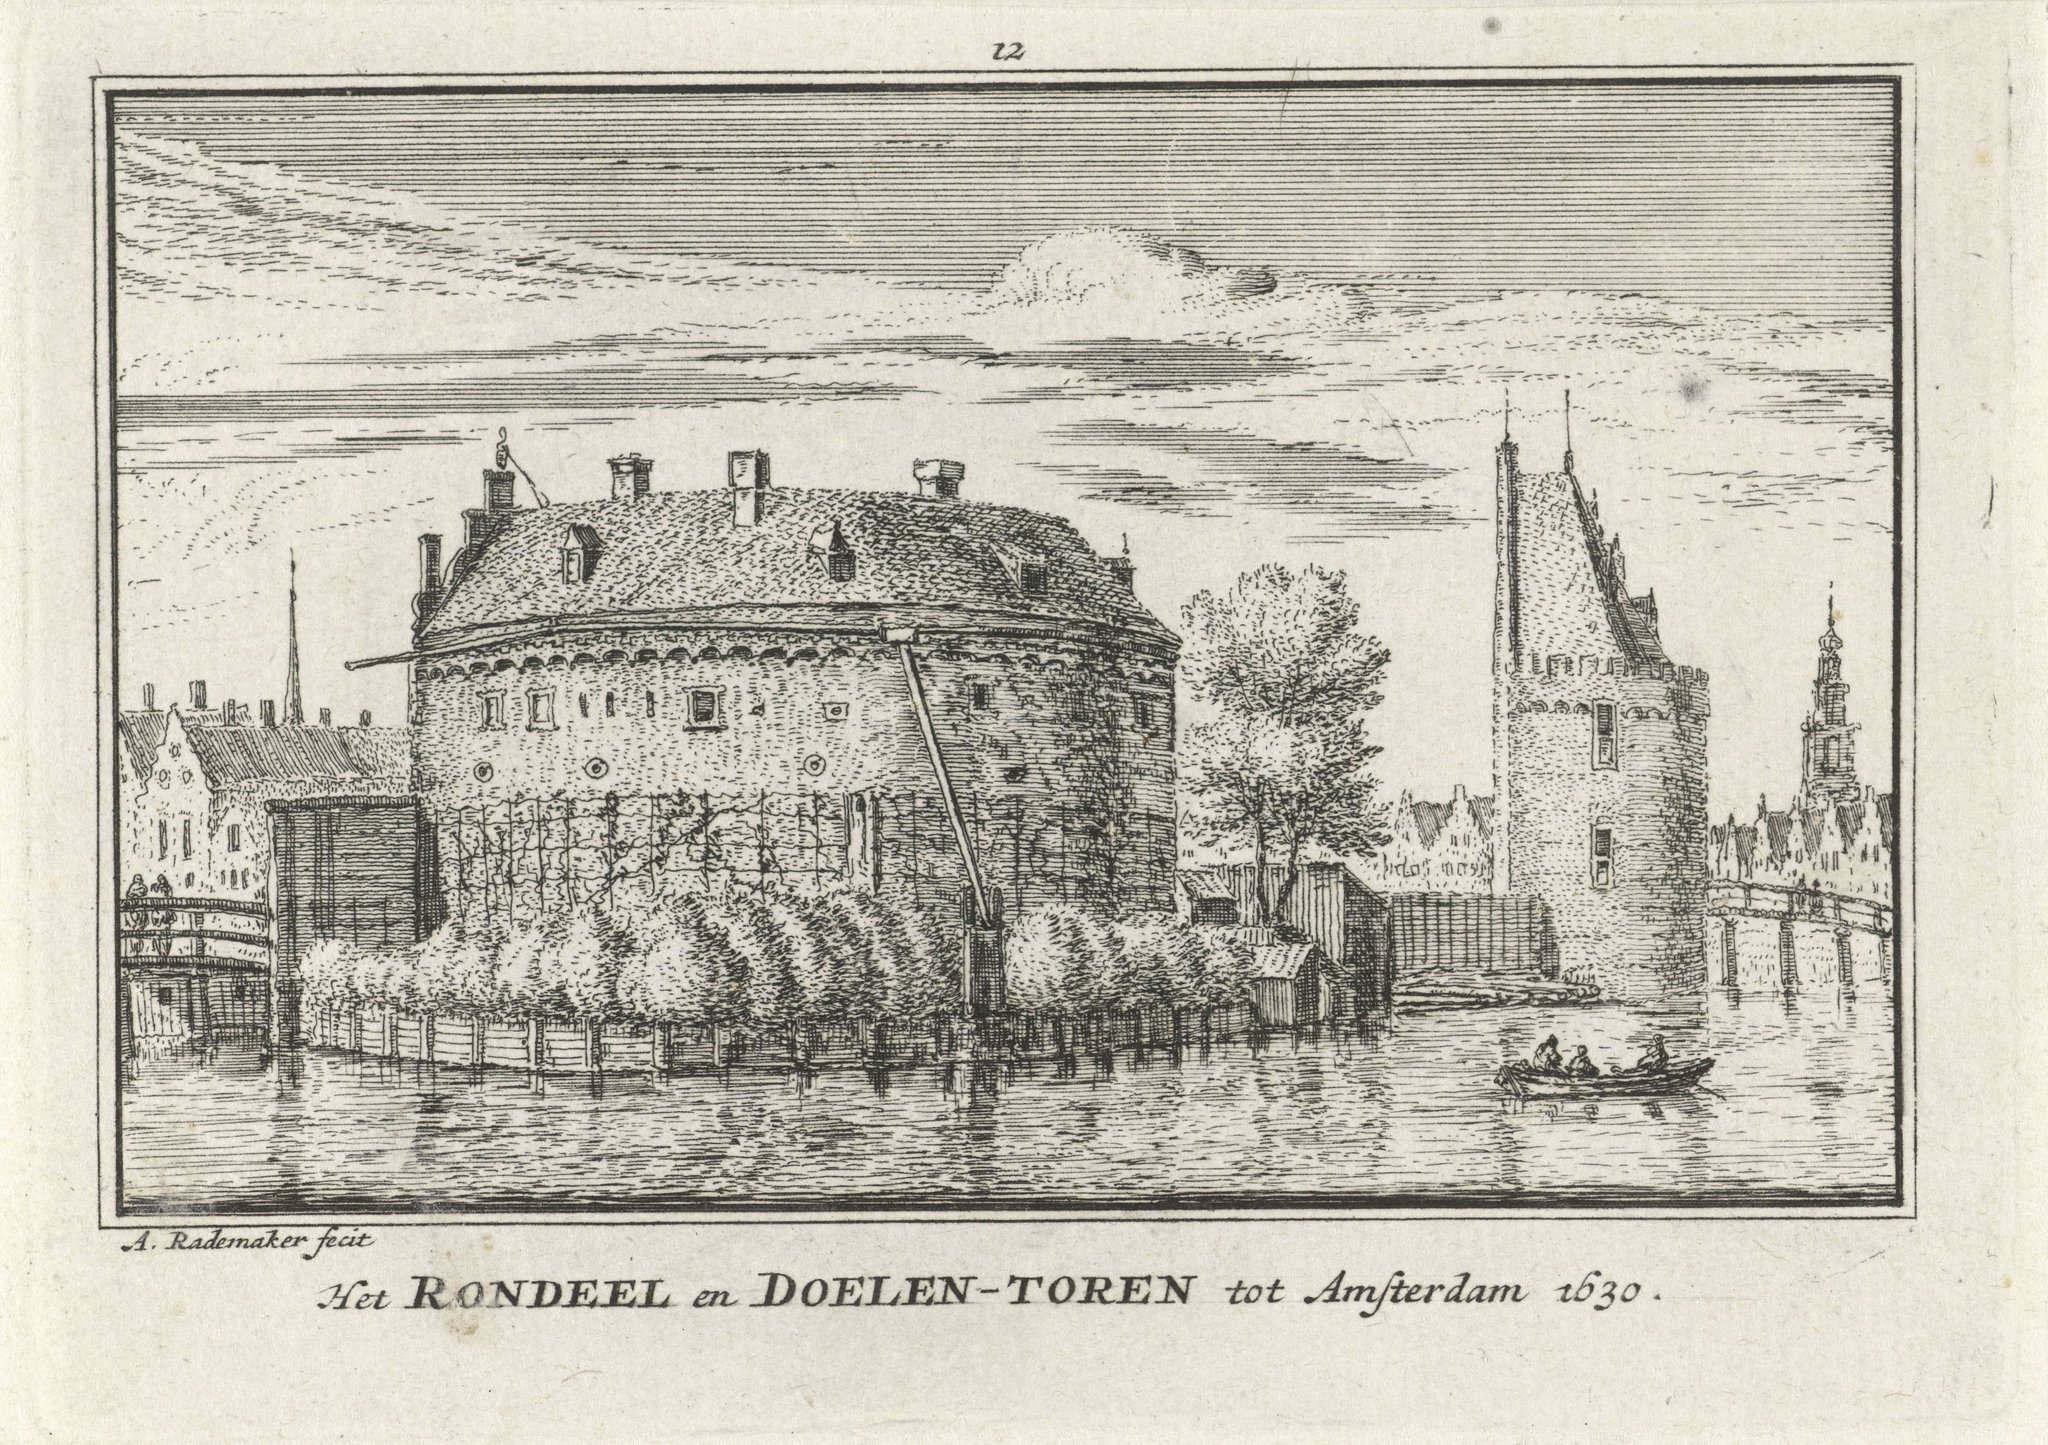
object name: book illustration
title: Het Rondeel en Doelen-Toren tot Amsterdam 1630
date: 1727-1733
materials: paper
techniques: etching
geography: amsterdam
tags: zuiderkerk, kloveniersdoelen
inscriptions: collector's mark: Lugt 2228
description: Illustratie uit: Abraham Rademaker, Matthaeus Brouërius van Niedek, Isaac Le Long, Kabinet van Nederlandsche en Kleefsche outheden en (...) voorname stads- en landgebouwen, Willem Barents en Antoni Schoonenburg: Amsterdam, 1727-1733, ill. nr. 12.